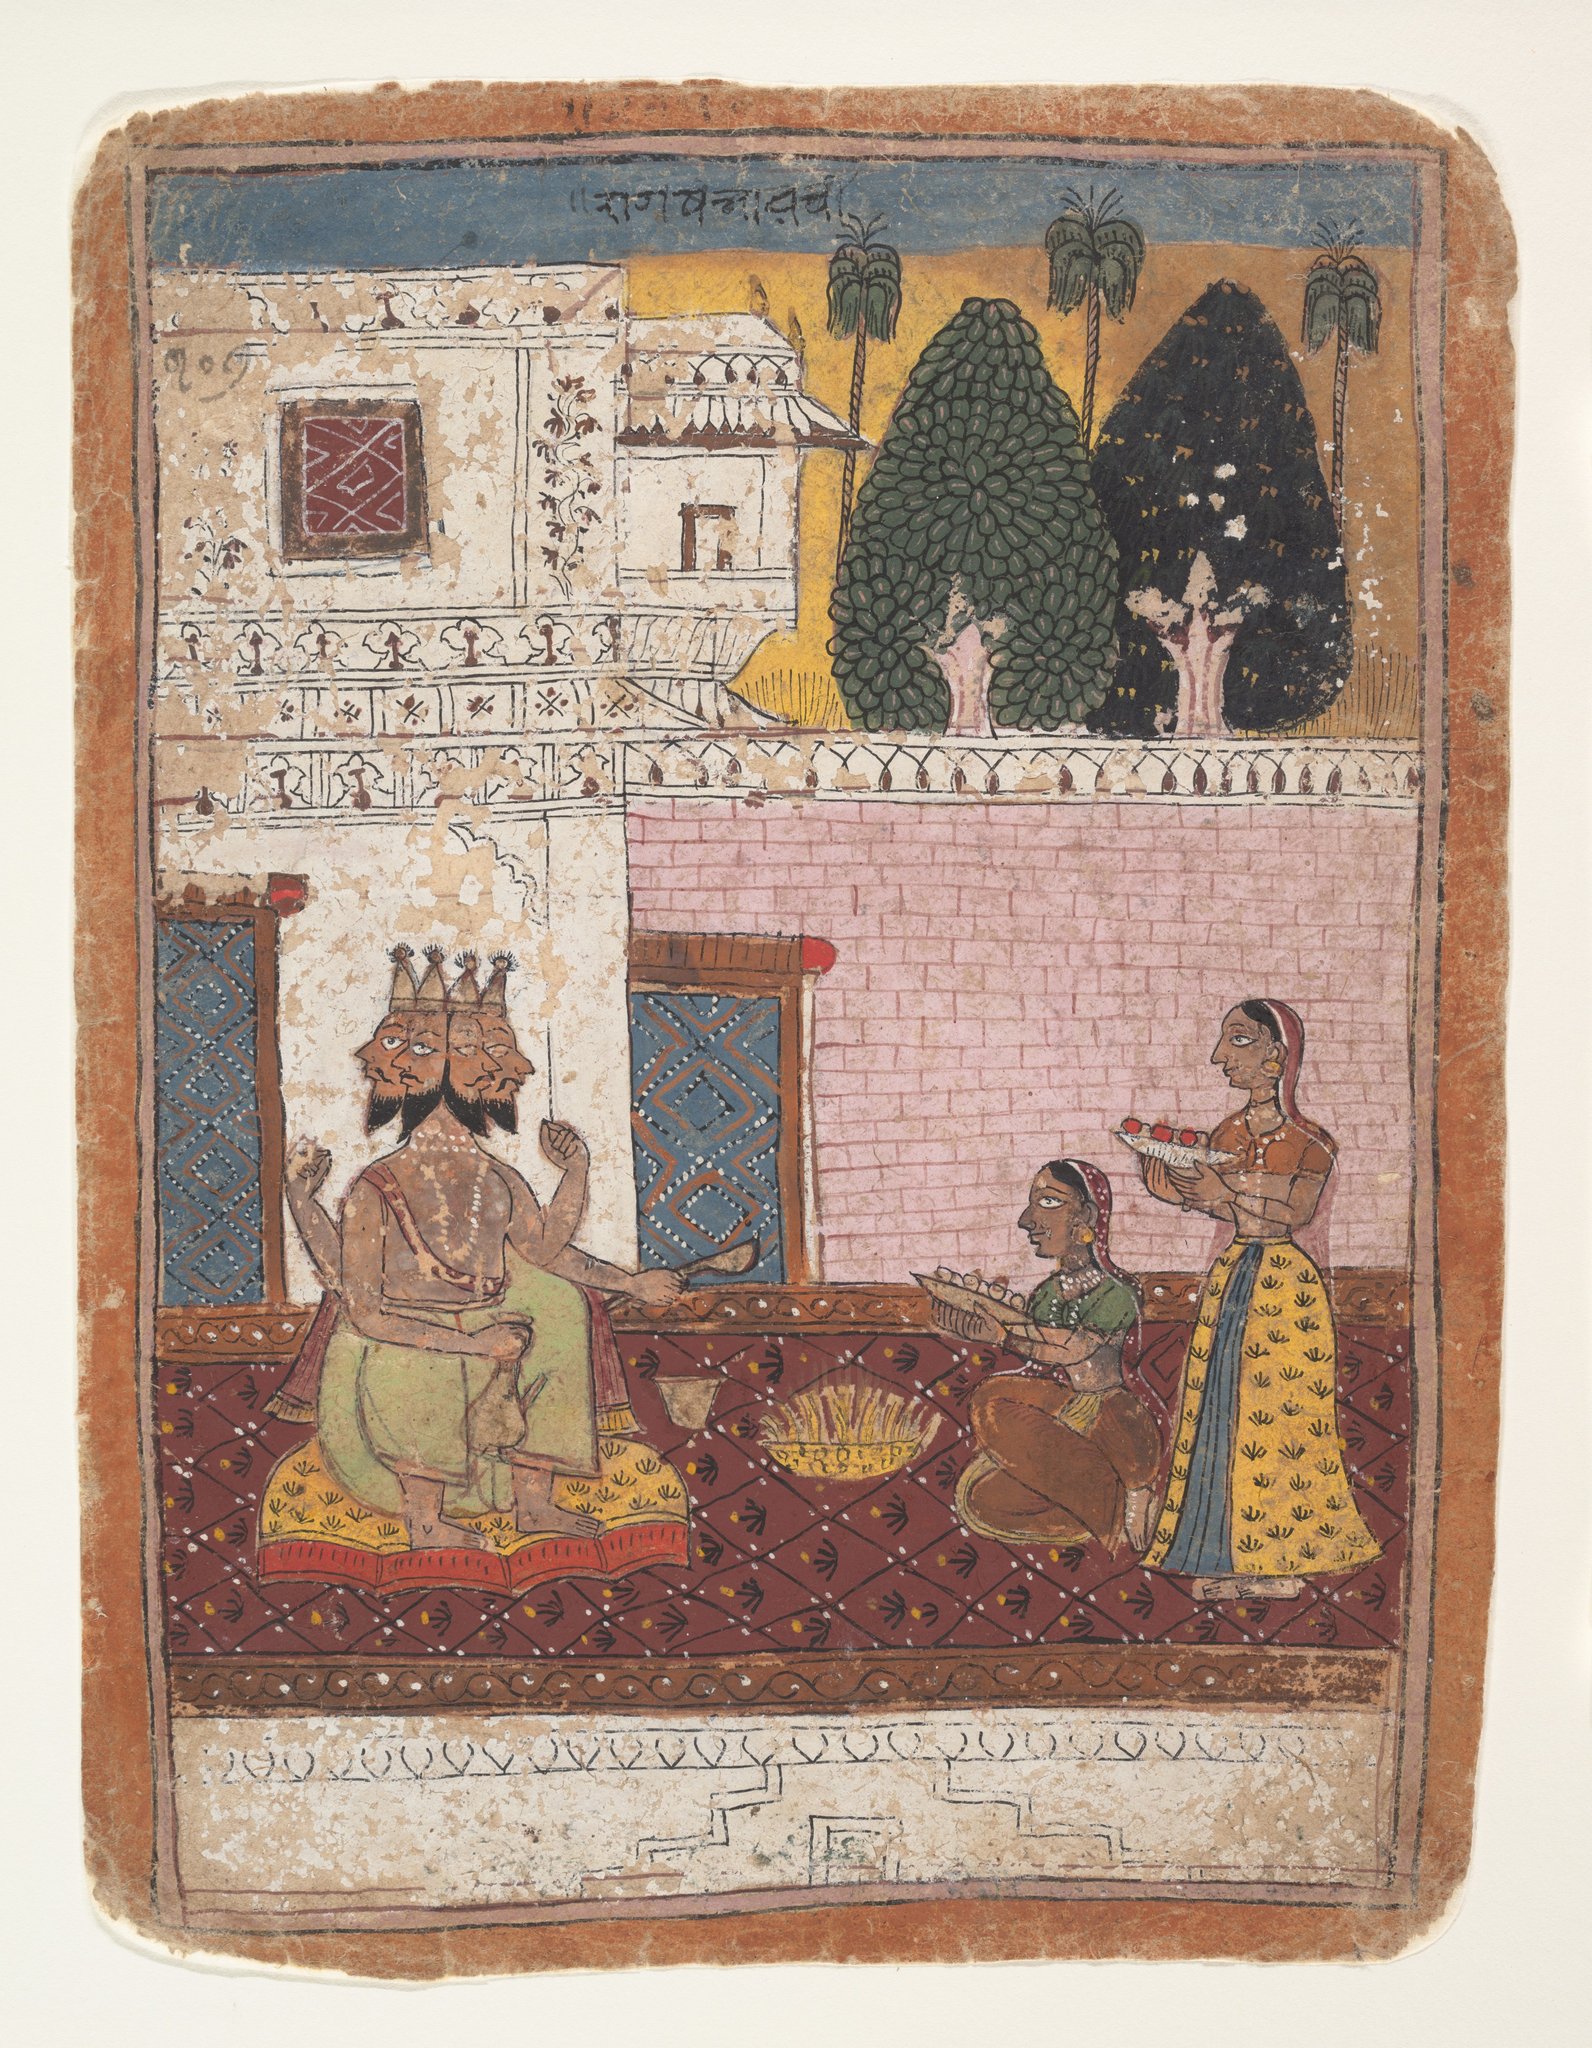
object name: folio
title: Khambavati Ragini: Page from a Dispersed Ragamala Series (Garland of Musical Modes)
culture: indian, rajasthan, marwar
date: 1700-1725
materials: ink, paper, watercolor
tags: fruit,women,fire,brahma